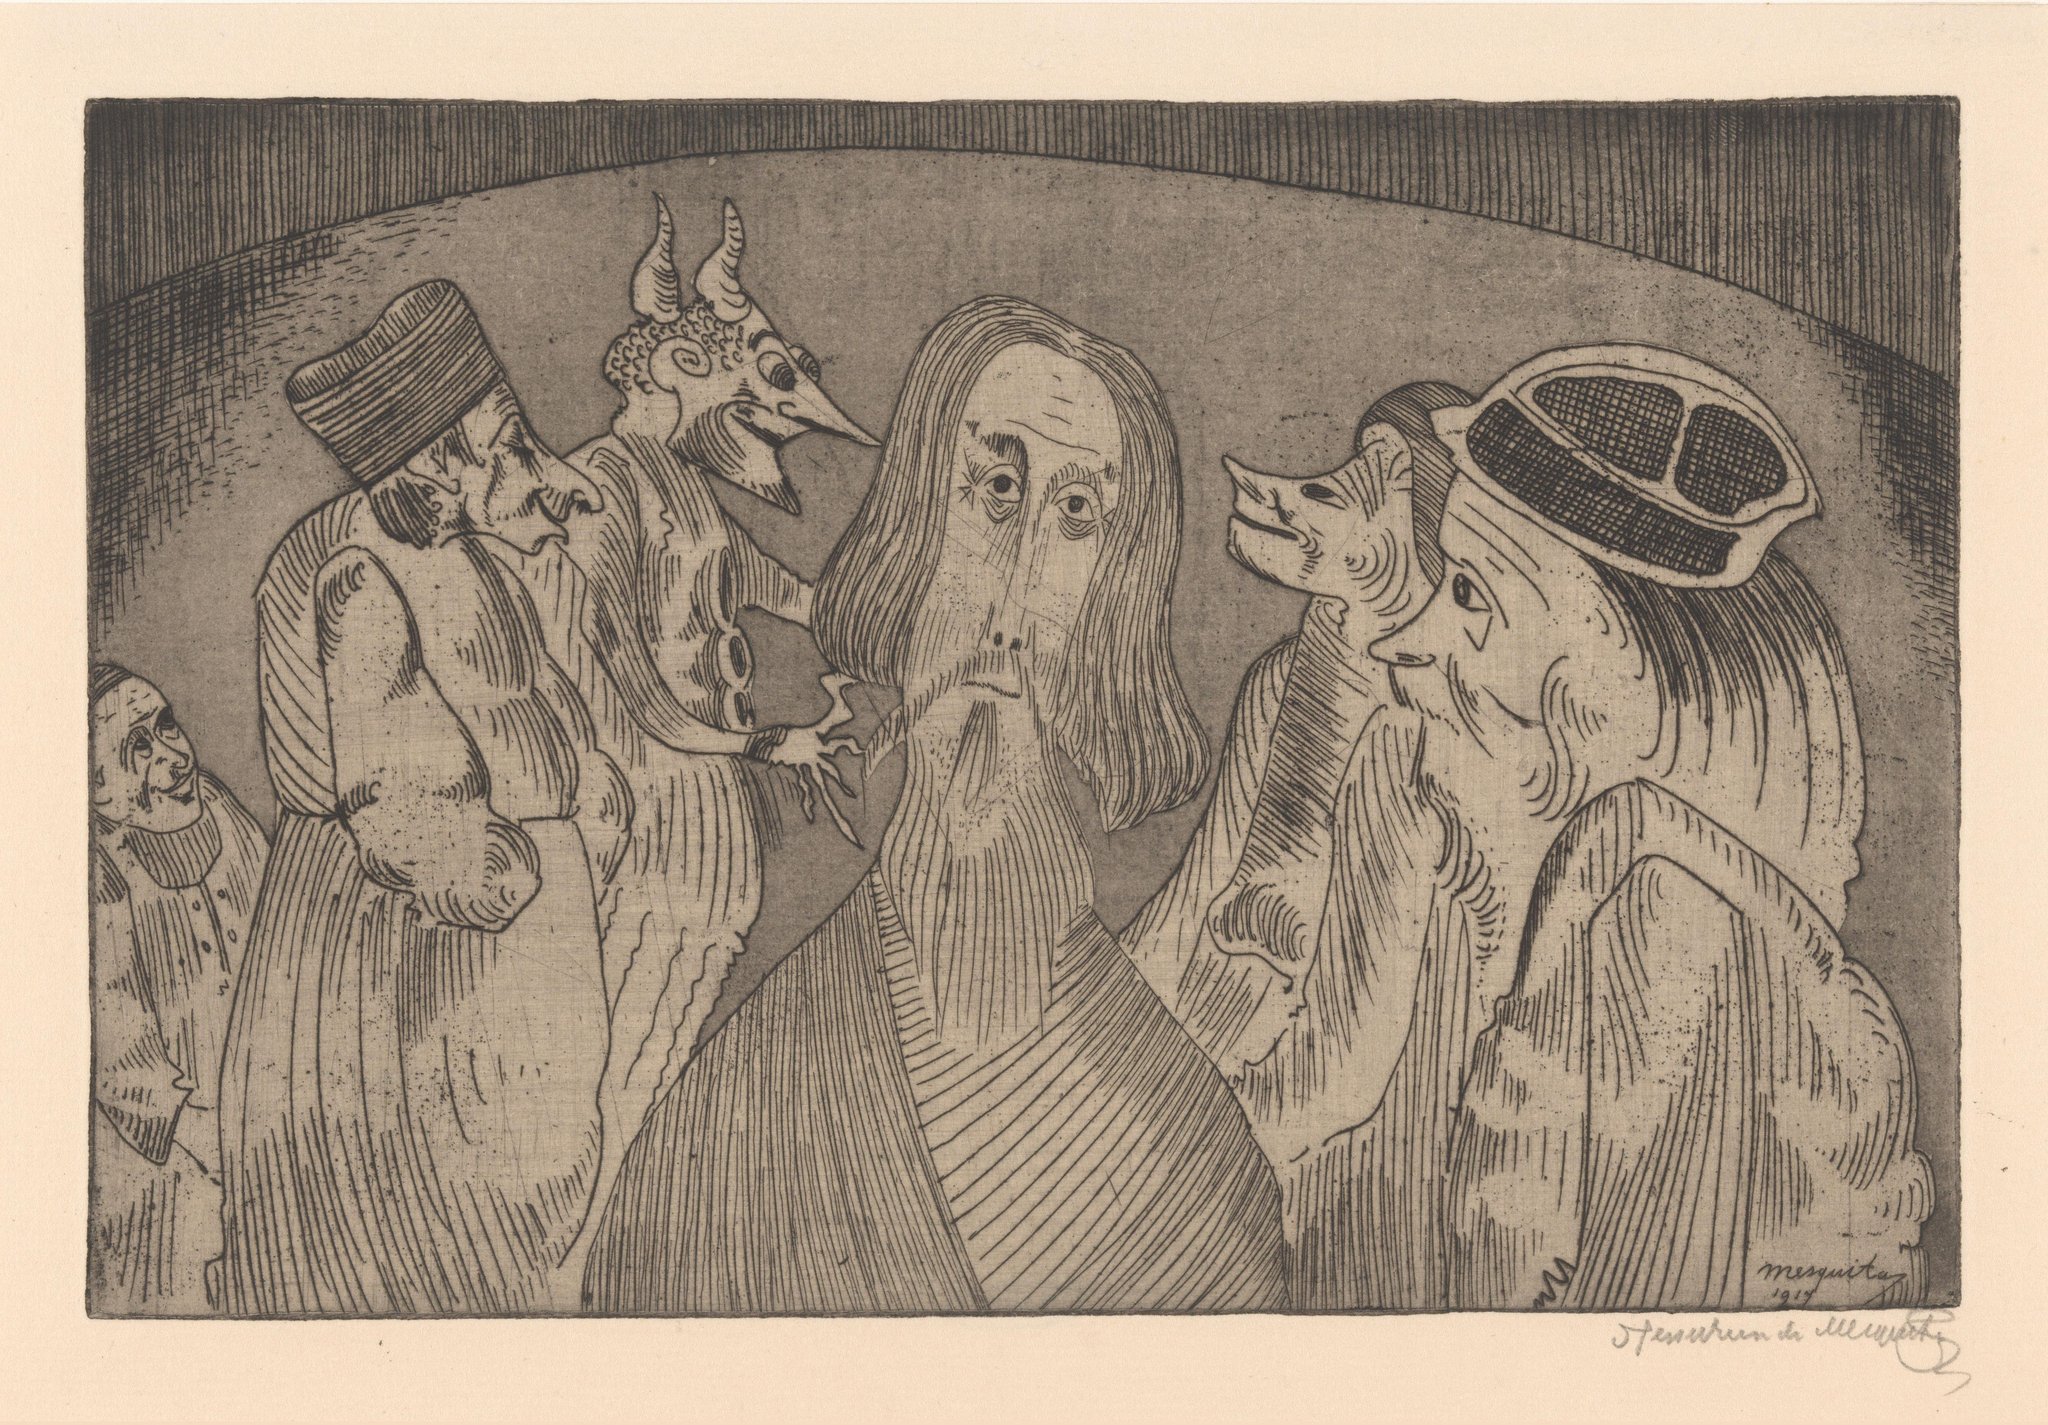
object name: print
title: Groteske verbeeldingen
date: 1917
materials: paper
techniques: etching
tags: caricatures (human types), devil(s) and demons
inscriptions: collector's mark: Lugt 2228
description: In het midden een man met een baard. Links een duivelachtige figuur.